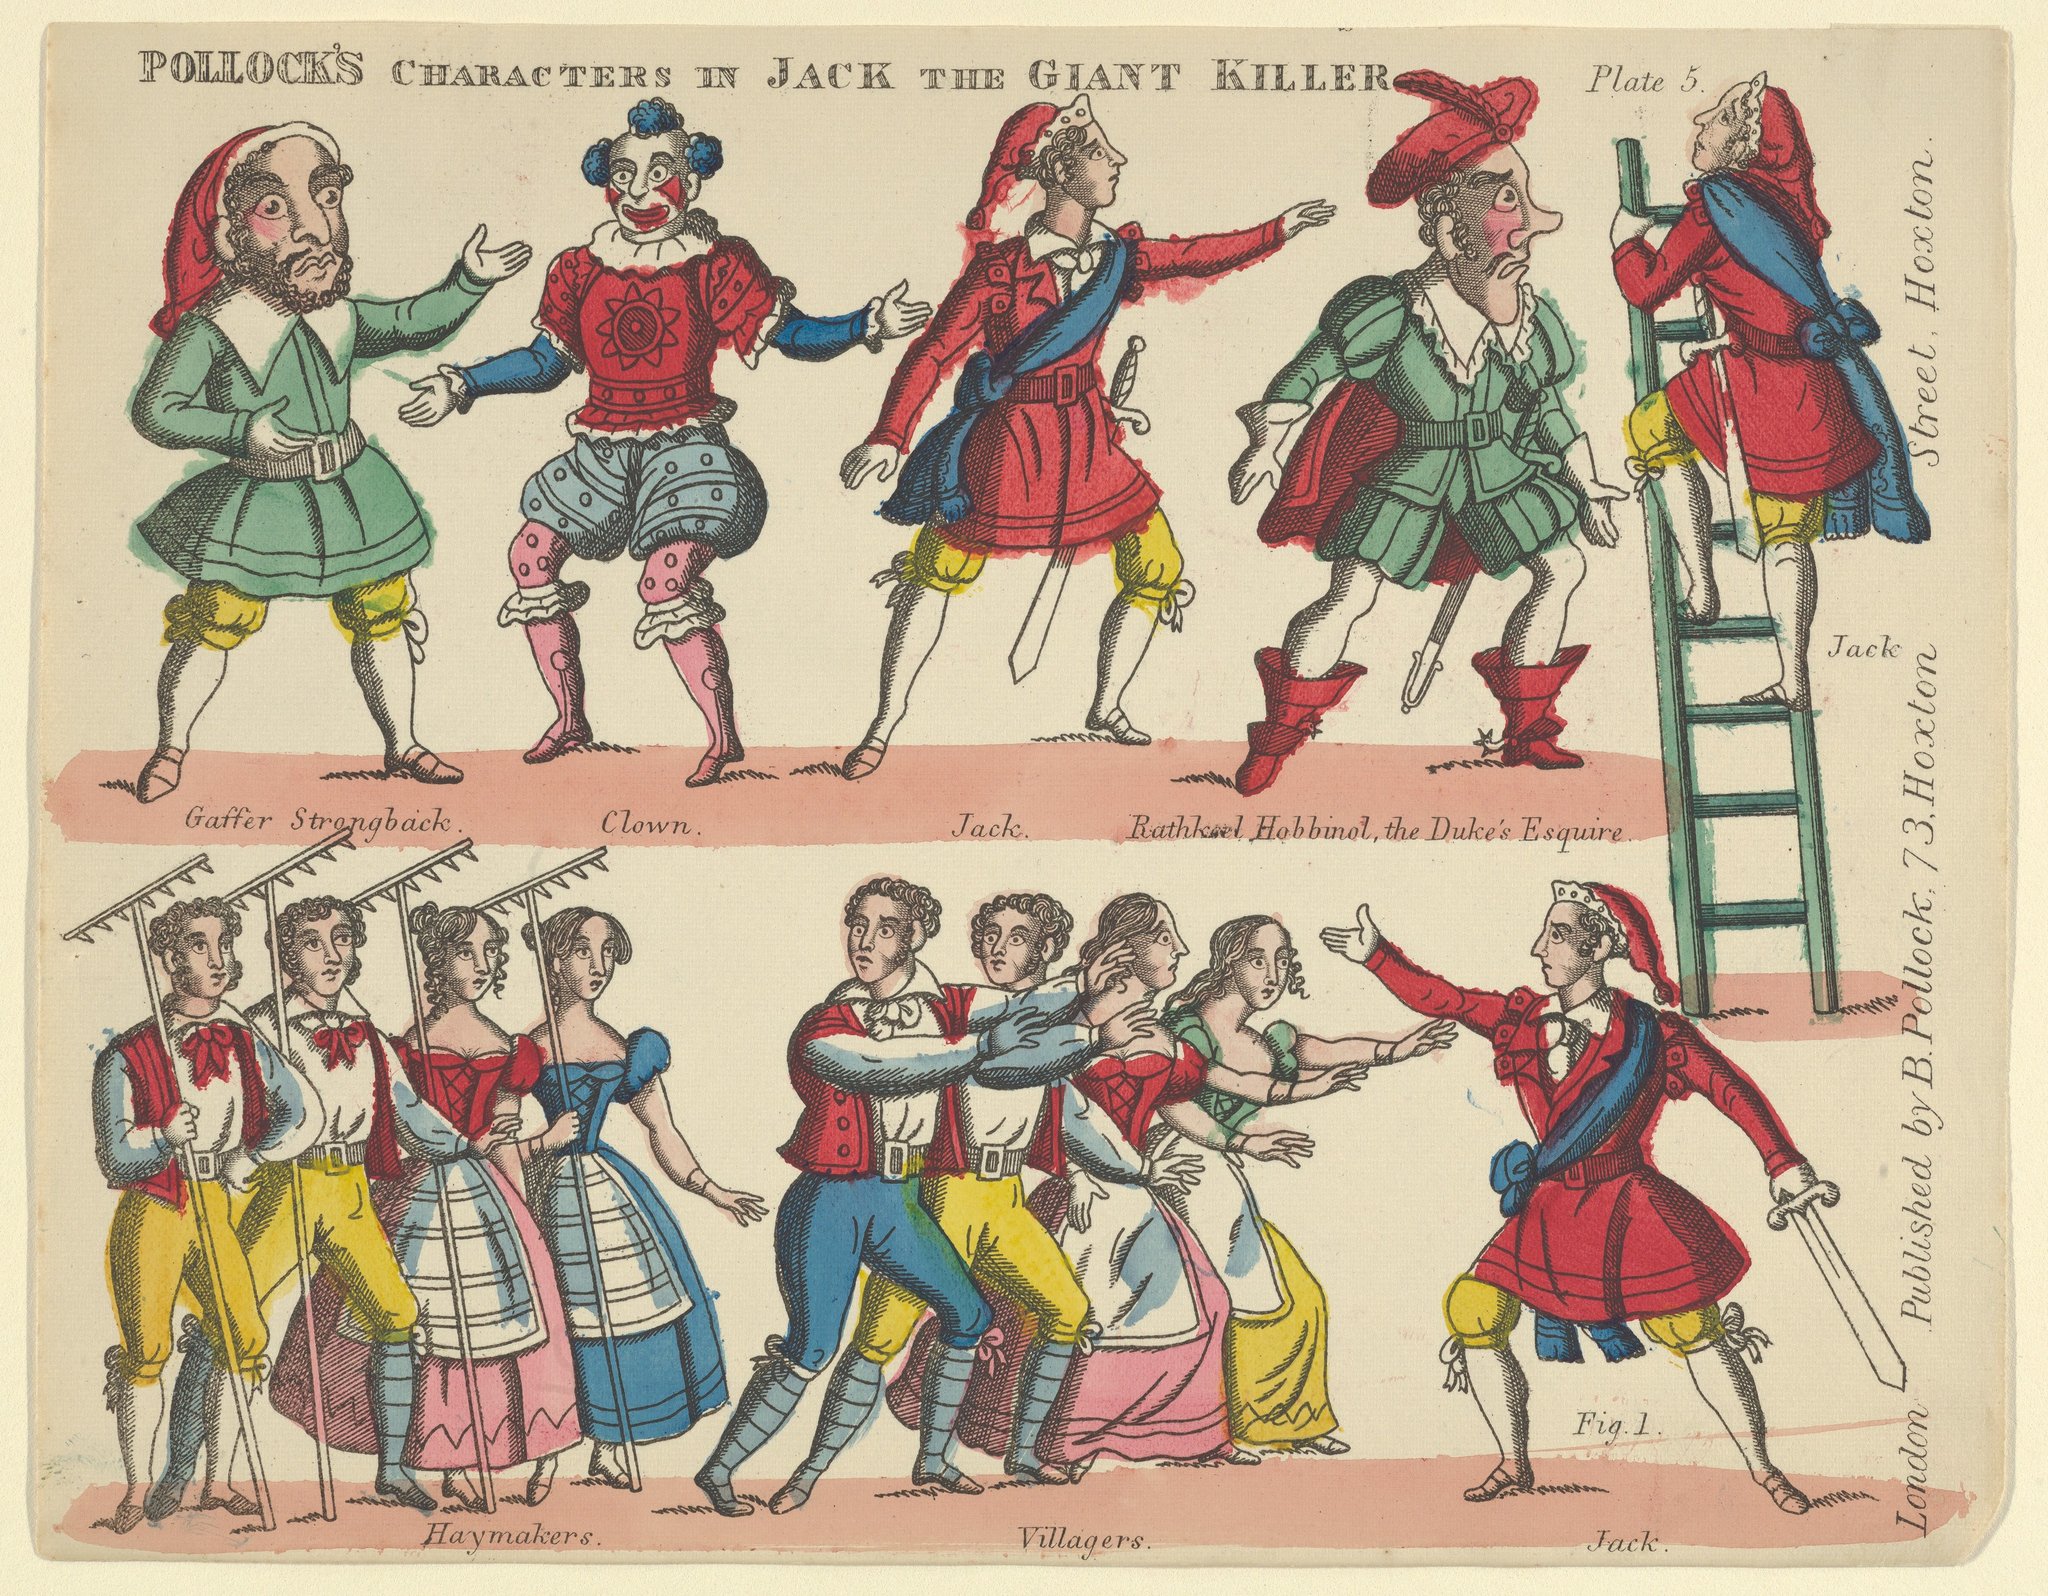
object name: print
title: Characters, from Jack and the Giant Killer, Plate 5 for a Toy Theater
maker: benjamin pollock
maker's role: publisher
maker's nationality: british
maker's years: 1857-1937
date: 1870-1890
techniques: lithograph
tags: satire,men,women,ladders